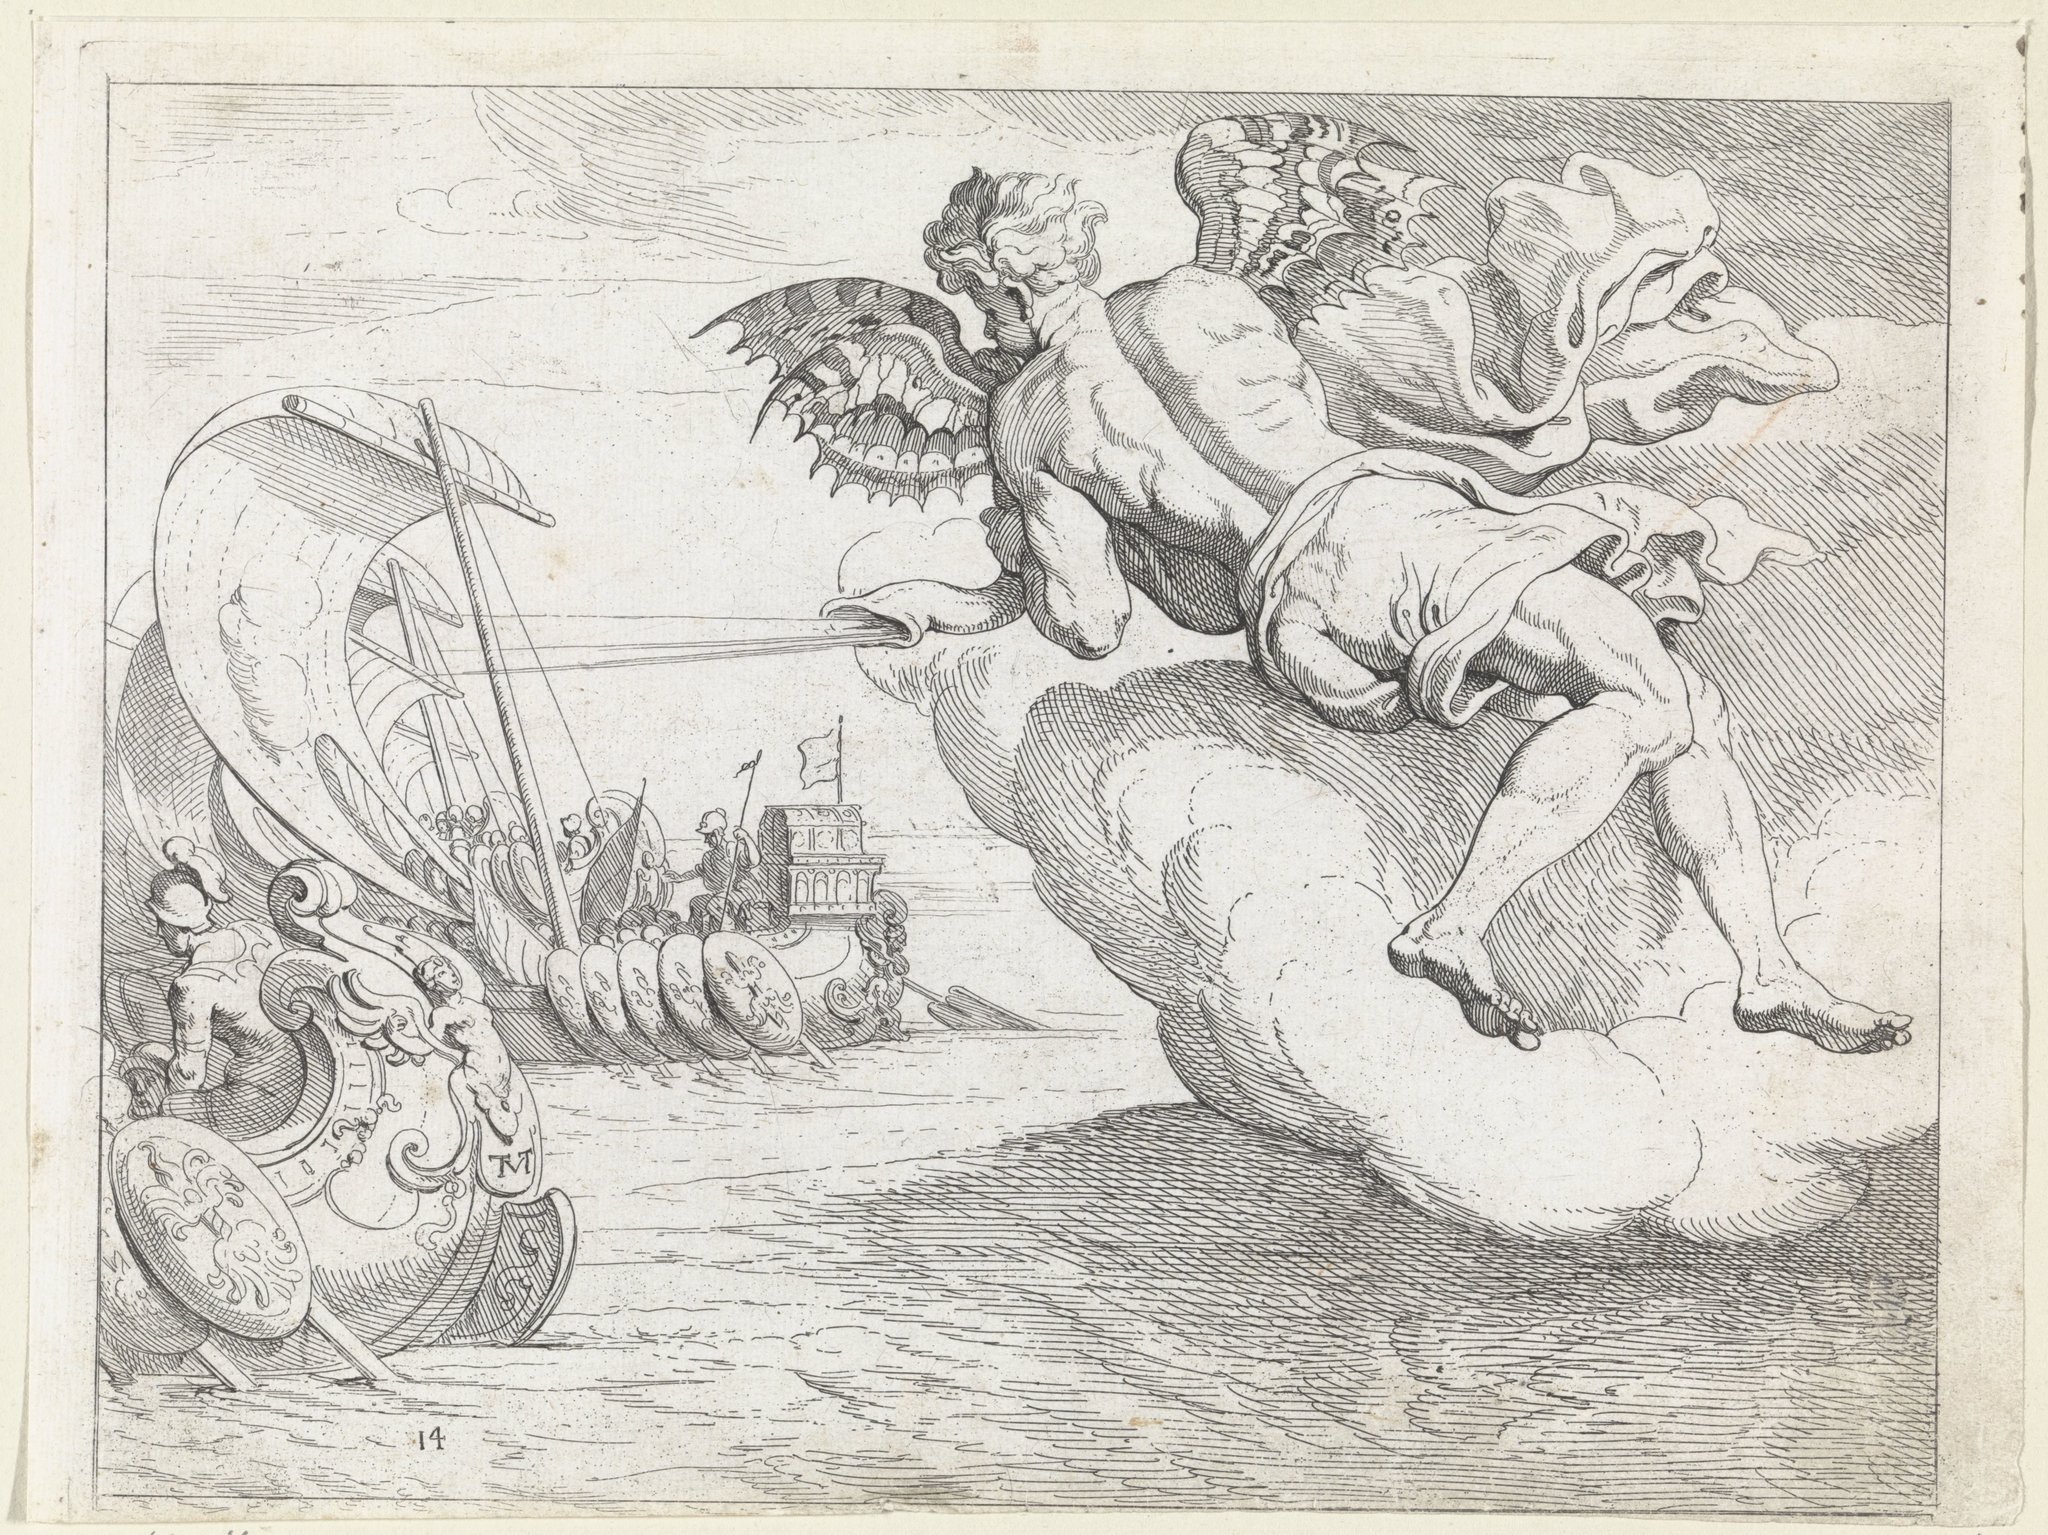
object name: print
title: Zephyrus blaast het schip van Odysseus vooruit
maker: theodoor van thulden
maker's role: draughtsman, painter, print maker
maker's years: 1606-1669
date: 1632-1633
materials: paper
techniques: engraving, etching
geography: paris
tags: wanderings of ulysses: from the cicones to scylla, (story of) zephyrus (favonius), the west wind; 'favonio o zeffiro' (ripa)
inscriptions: collector's mark: Lugt 2228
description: Zephyrus, de god van de westenwind, blaast de schepen van Odysseus vooruit.